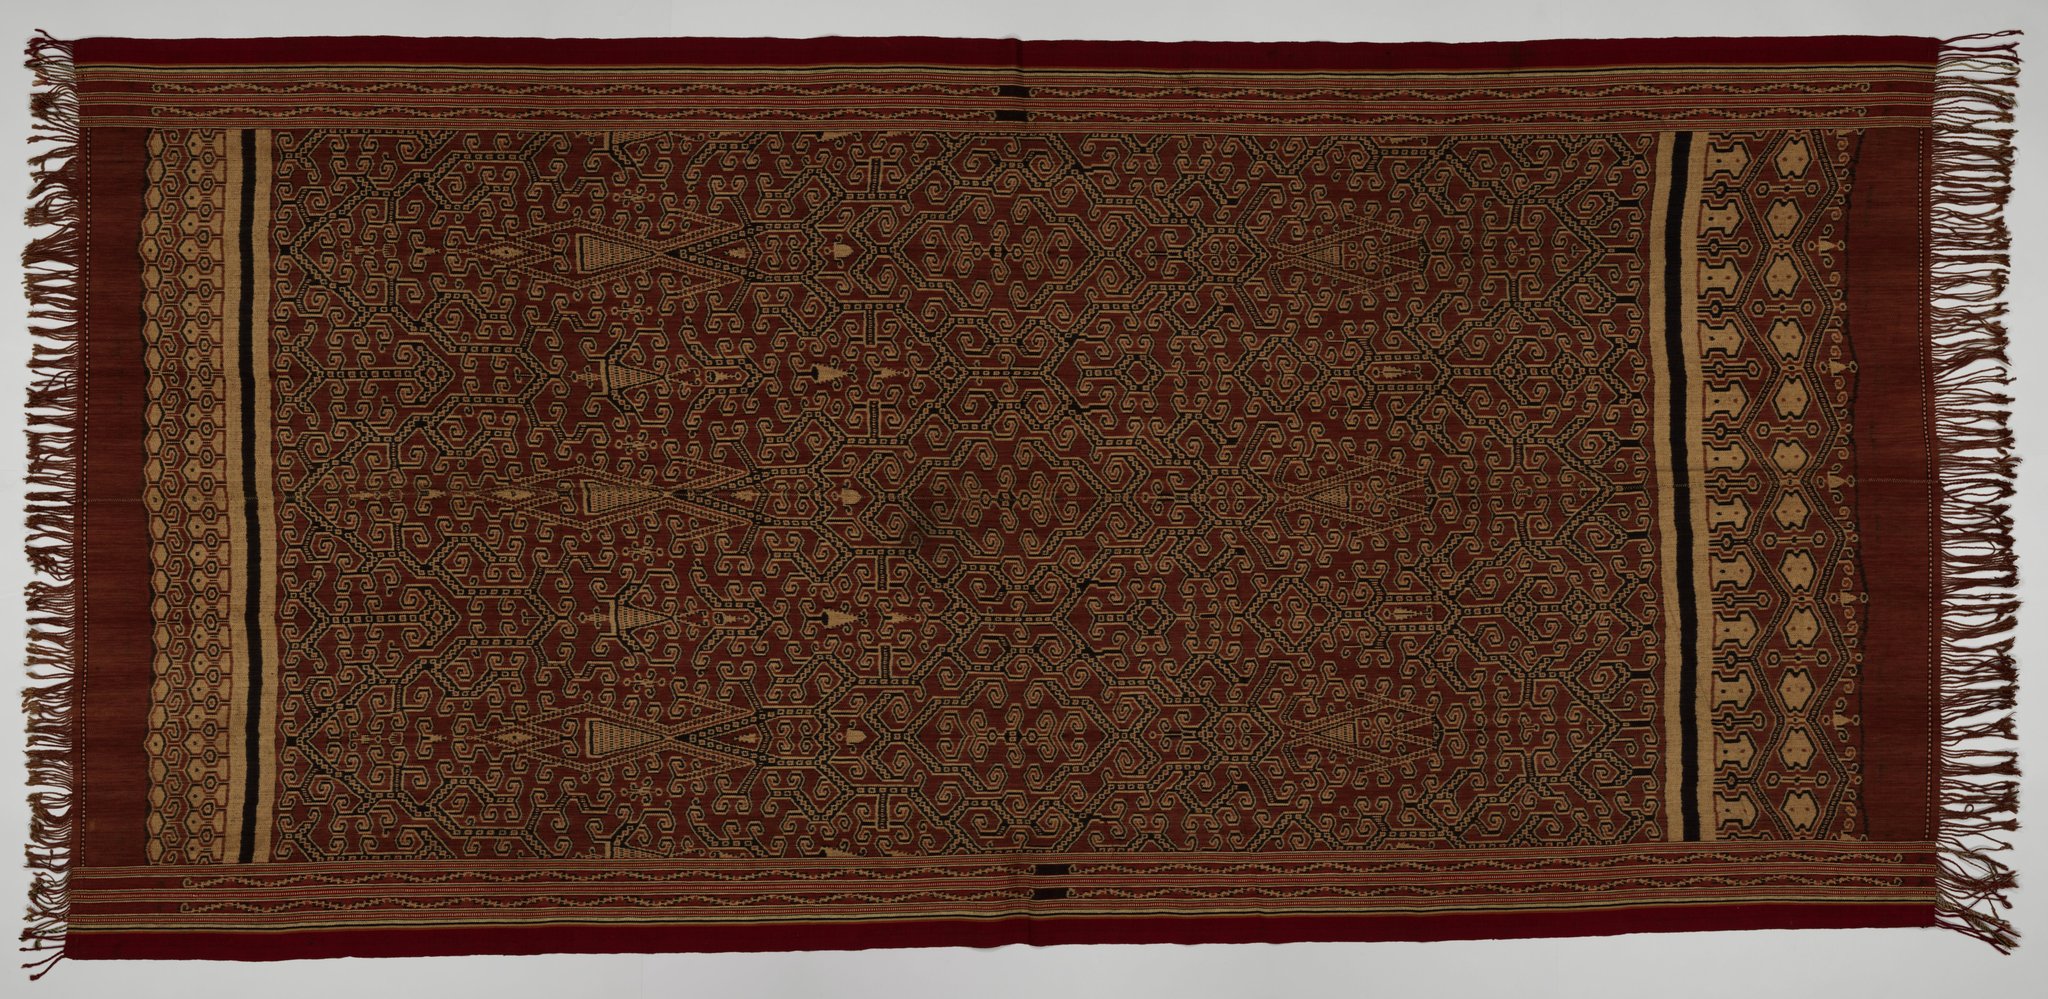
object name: cloth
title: Pua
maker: Anonymous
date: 1900-1949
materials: cotton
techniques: weave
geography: sarawak